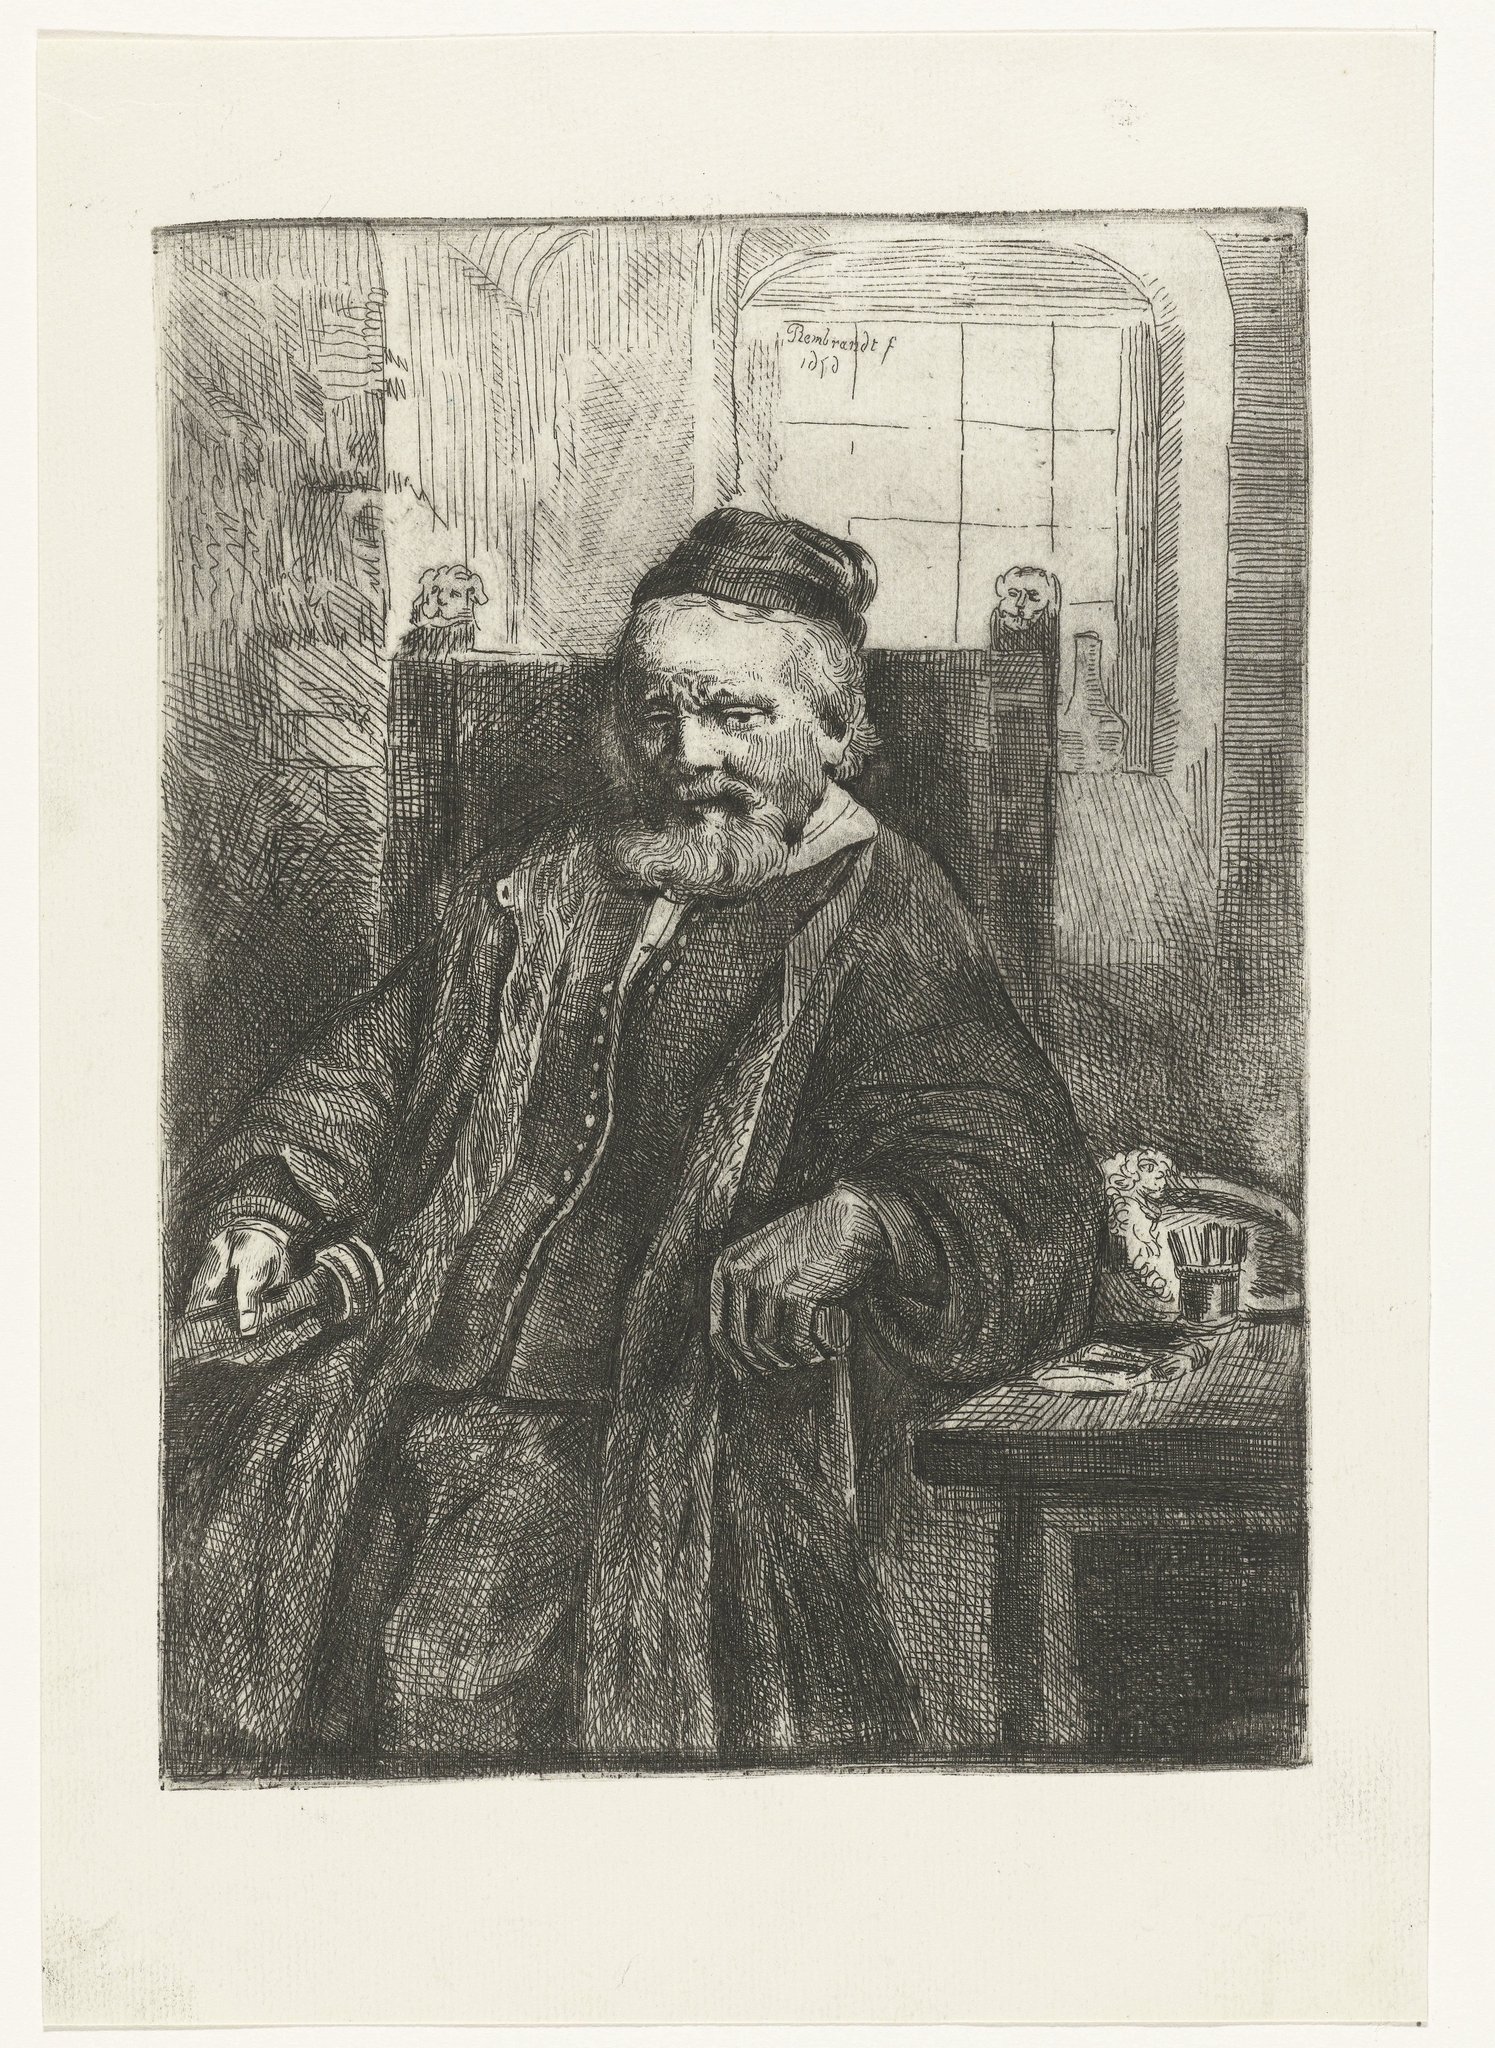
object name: print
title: Jan Lutma, goldsmith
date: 1656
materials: paper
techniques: etching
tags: print maker, silversmith, johannes lutma (1584-1669), historical persons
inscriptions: collector's mark: Lugt 2228